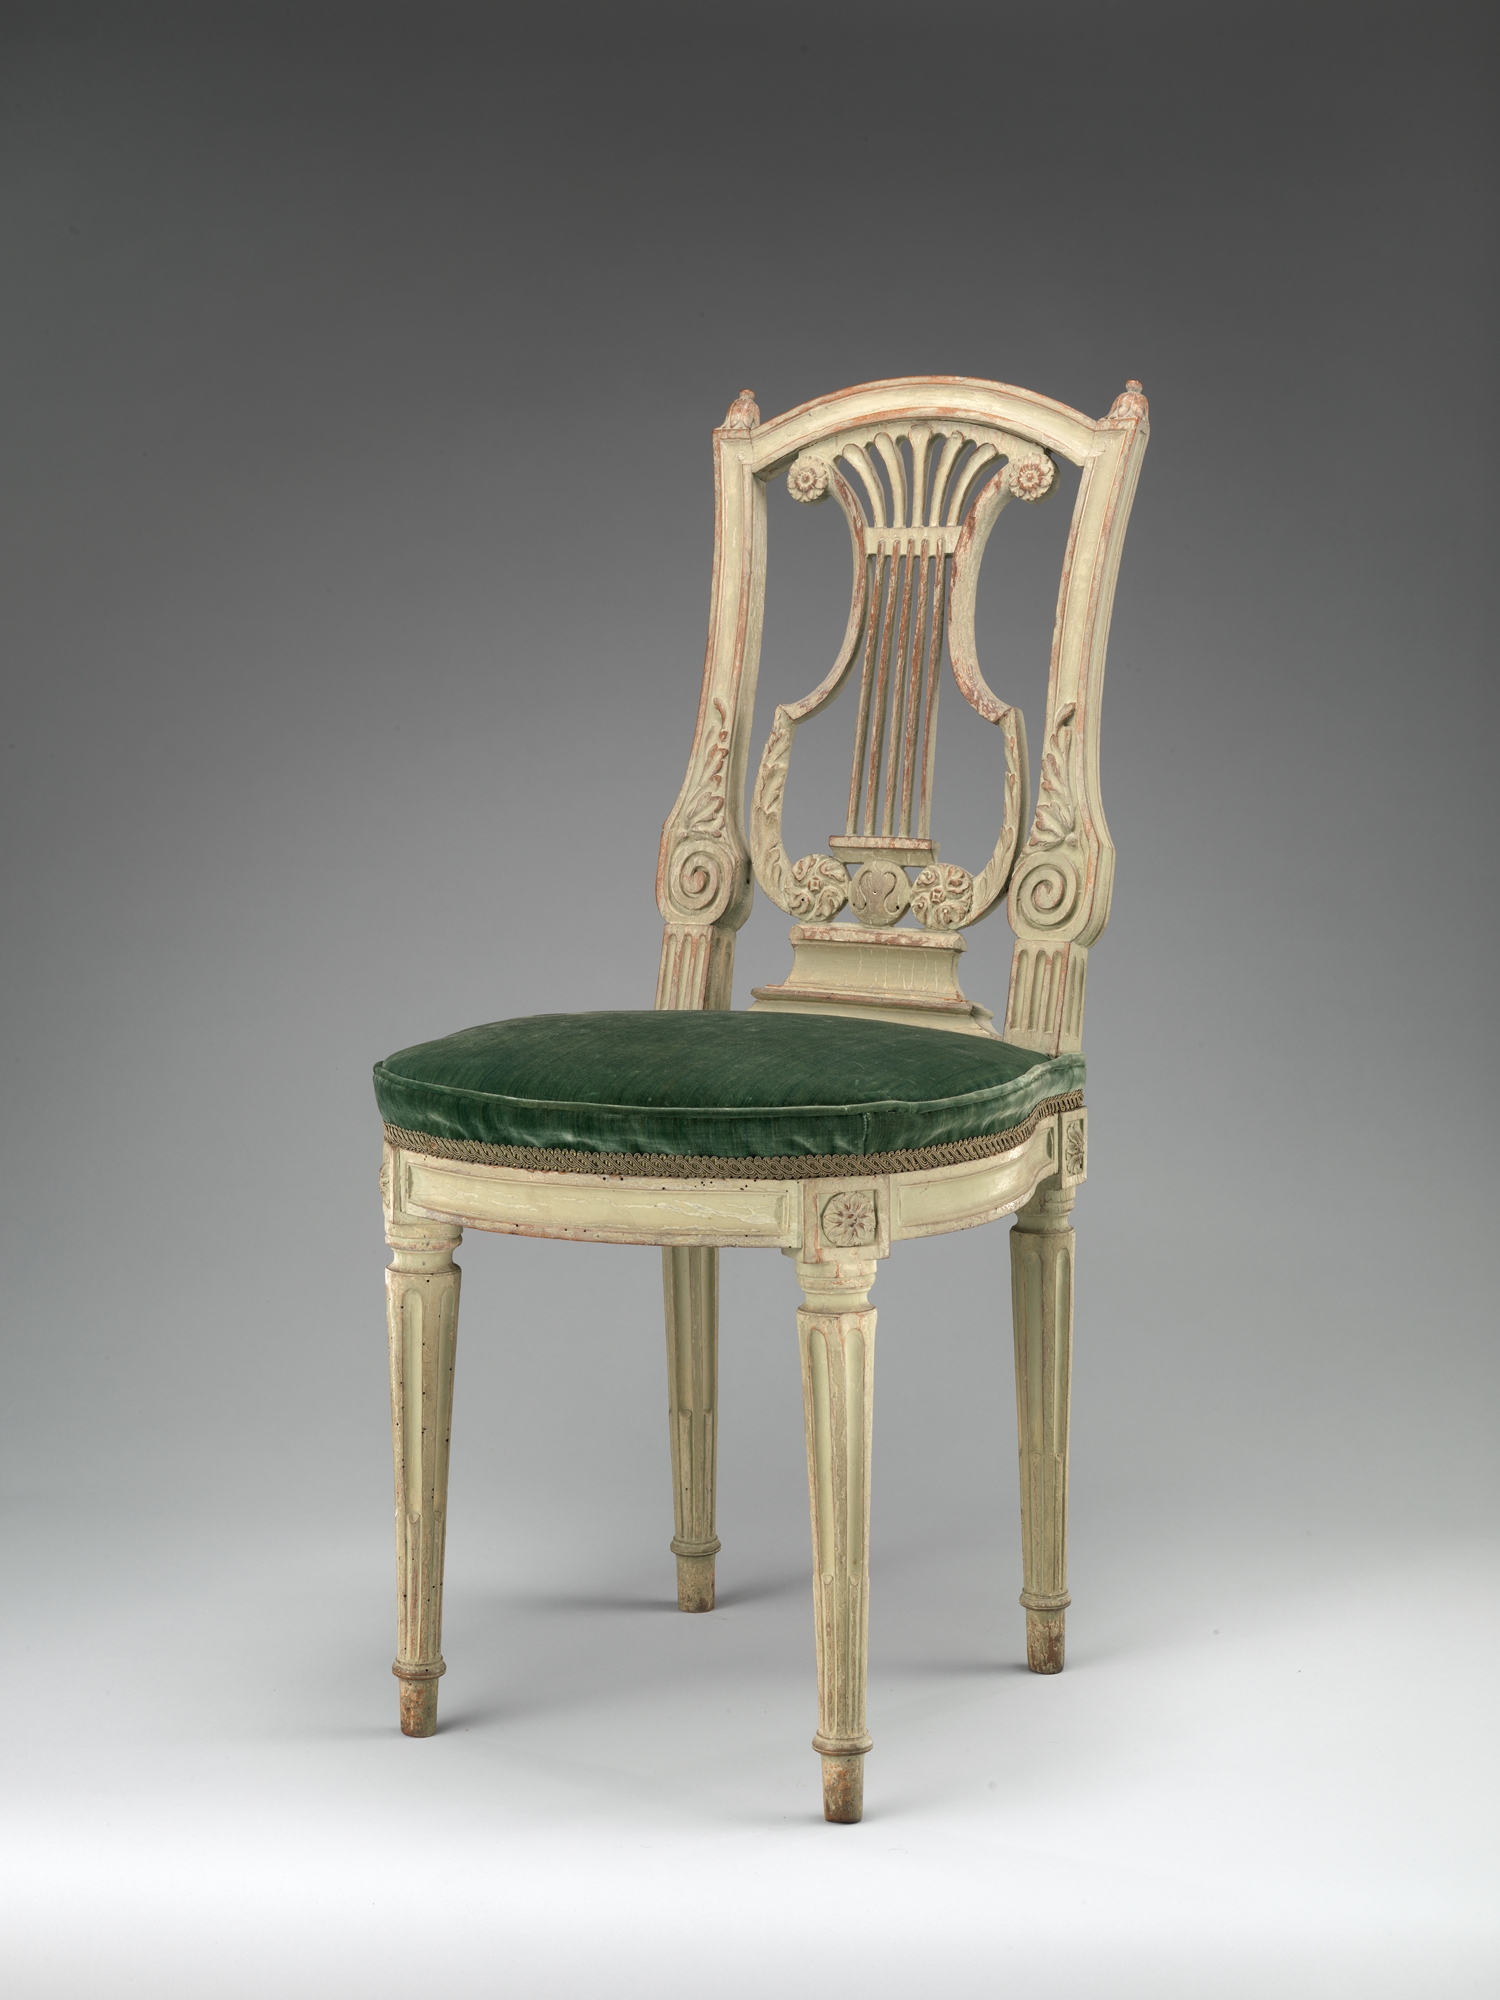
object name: side chair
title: Side chair (one of a pair)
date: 1780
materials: velvet, wood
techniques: carving, painting